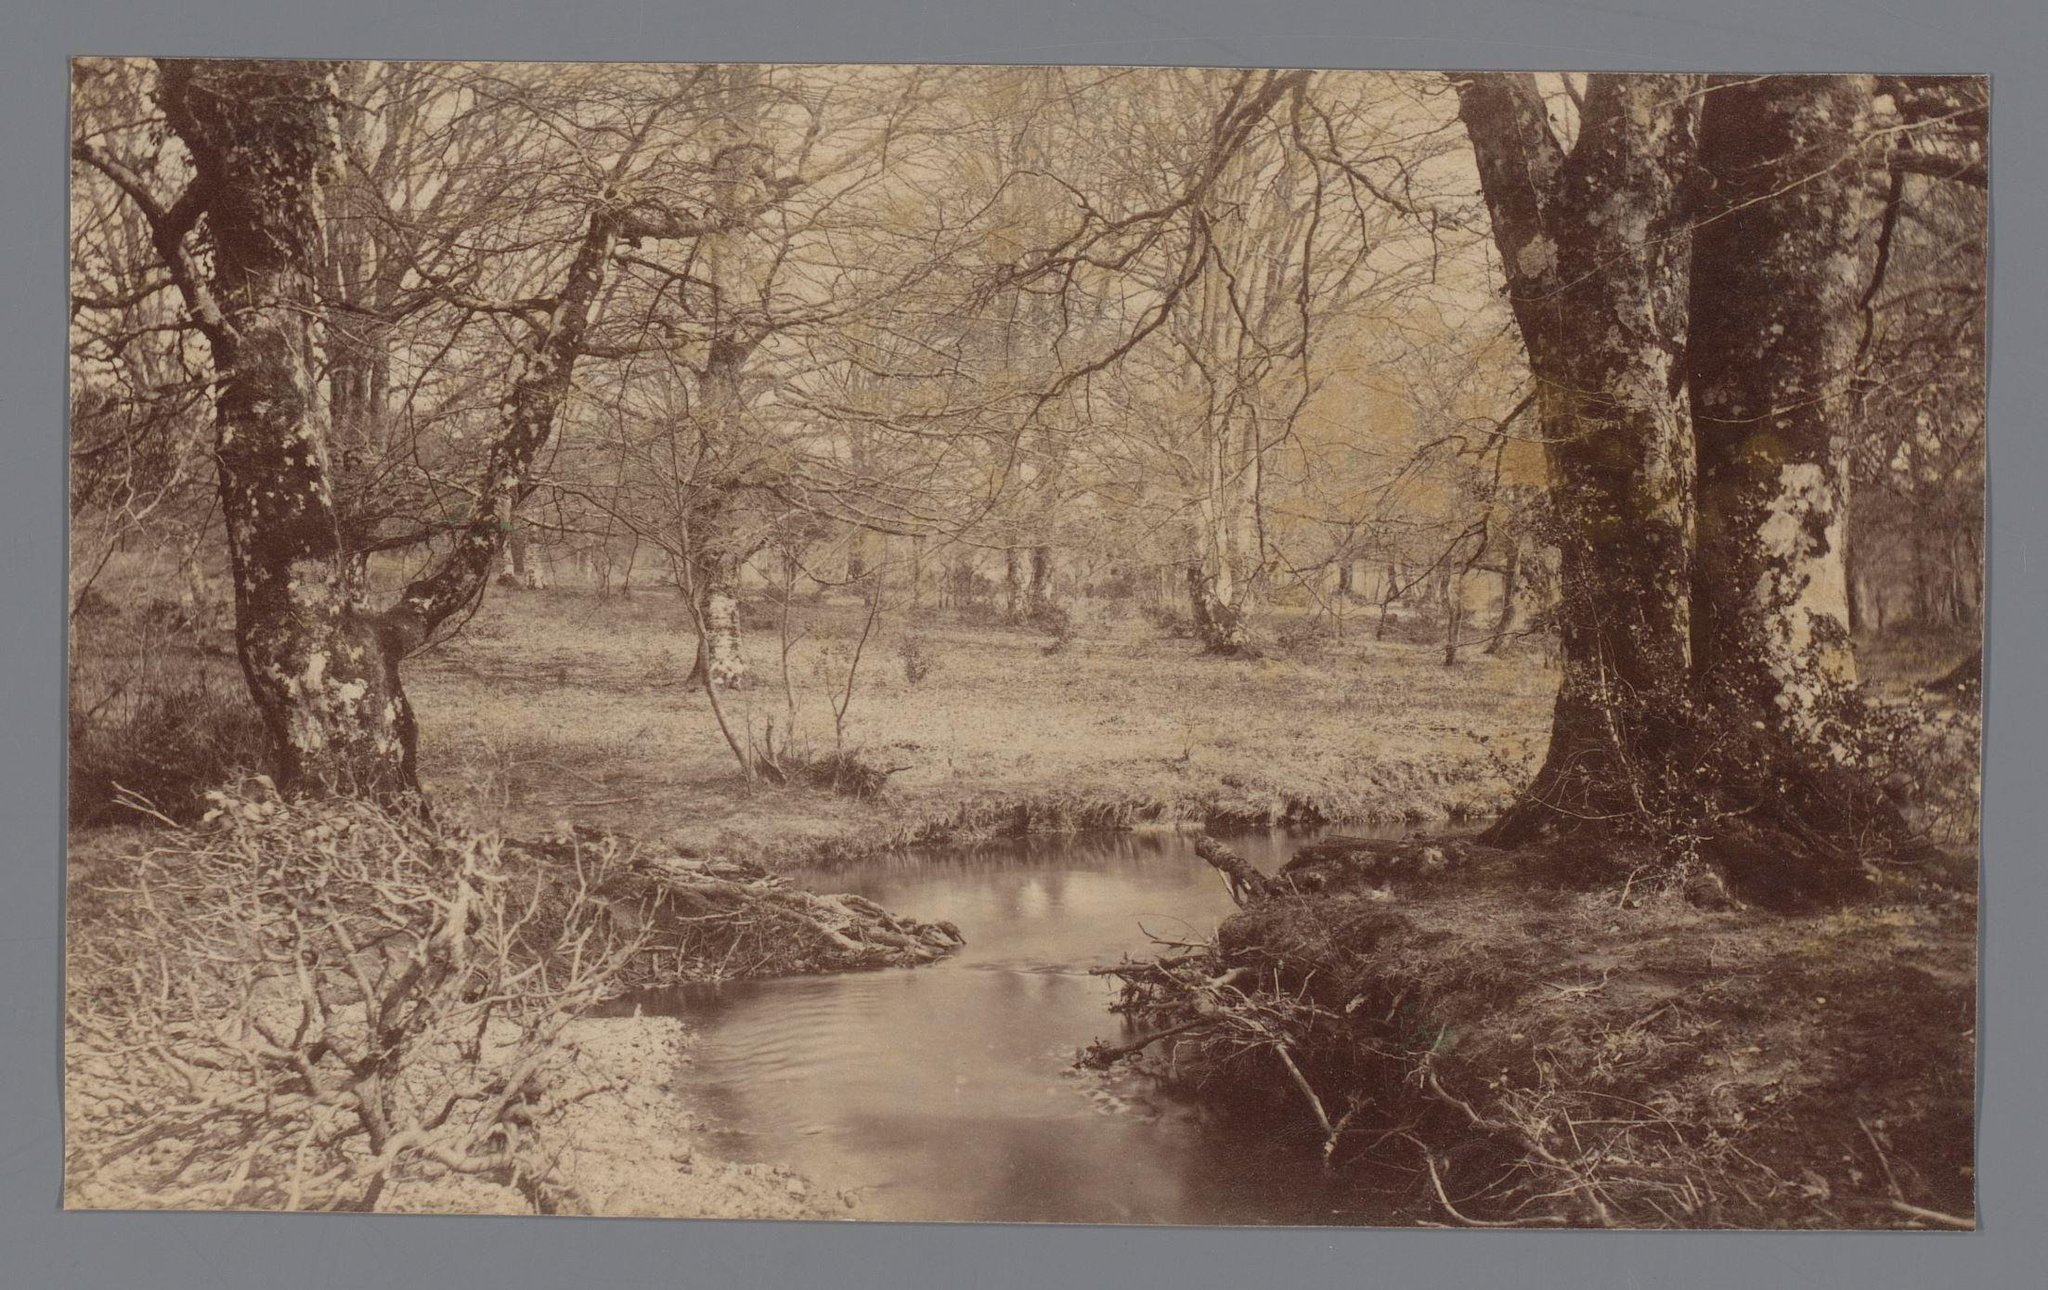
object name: photograph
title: Landschap met meanderende rivier en kale bomen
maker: Anonymous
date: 1870-1890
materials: paper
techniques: albumen print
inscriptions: inscription: ‘Pat’, inscription: ‘....[?]//Idat Road/Rock [?]’